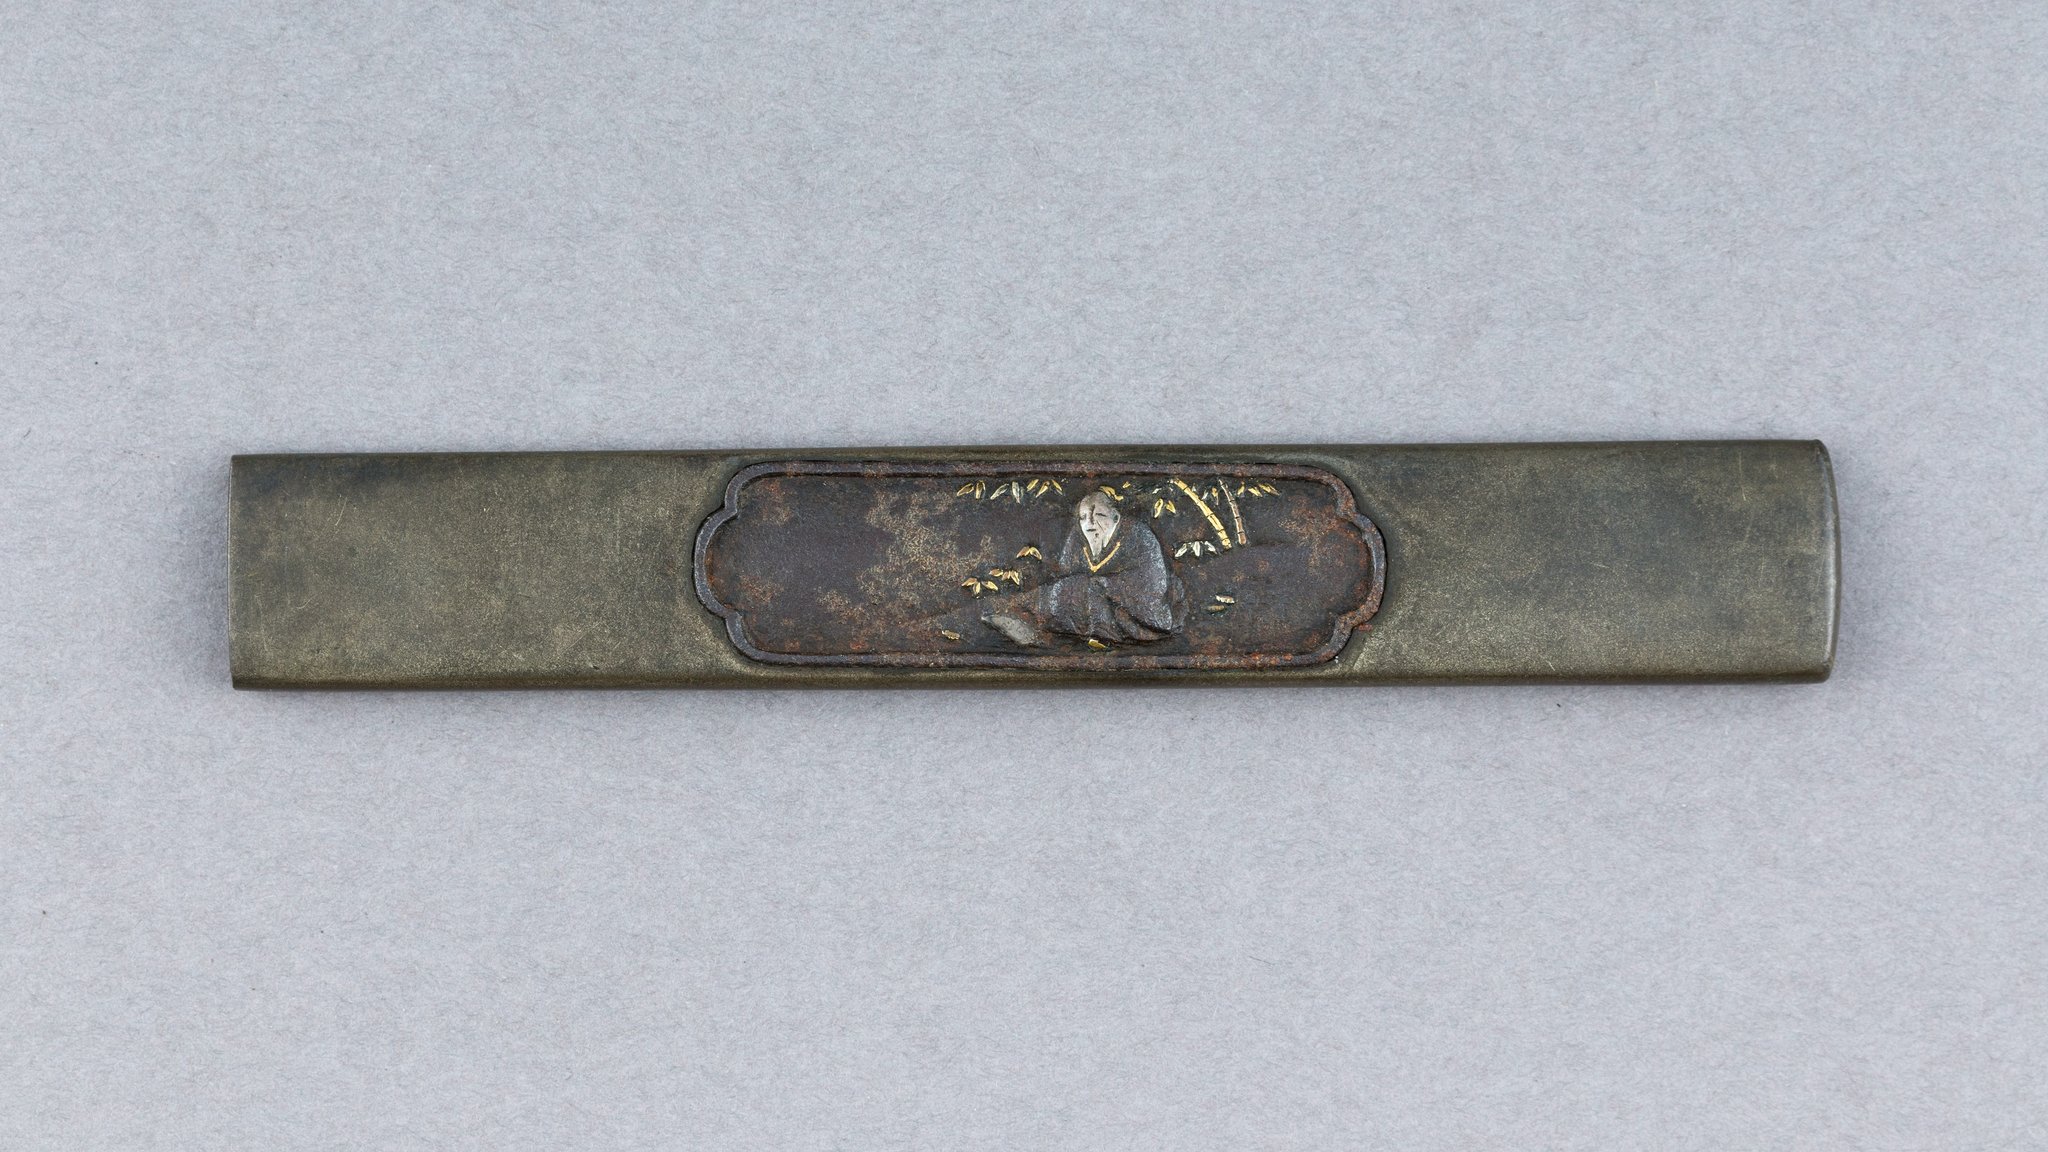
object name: knife handle kozuka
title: Knife Handle (Kozuka)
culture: japanese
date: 1615-1868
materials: silver alloy, gold, iron, silver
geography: japan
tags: men